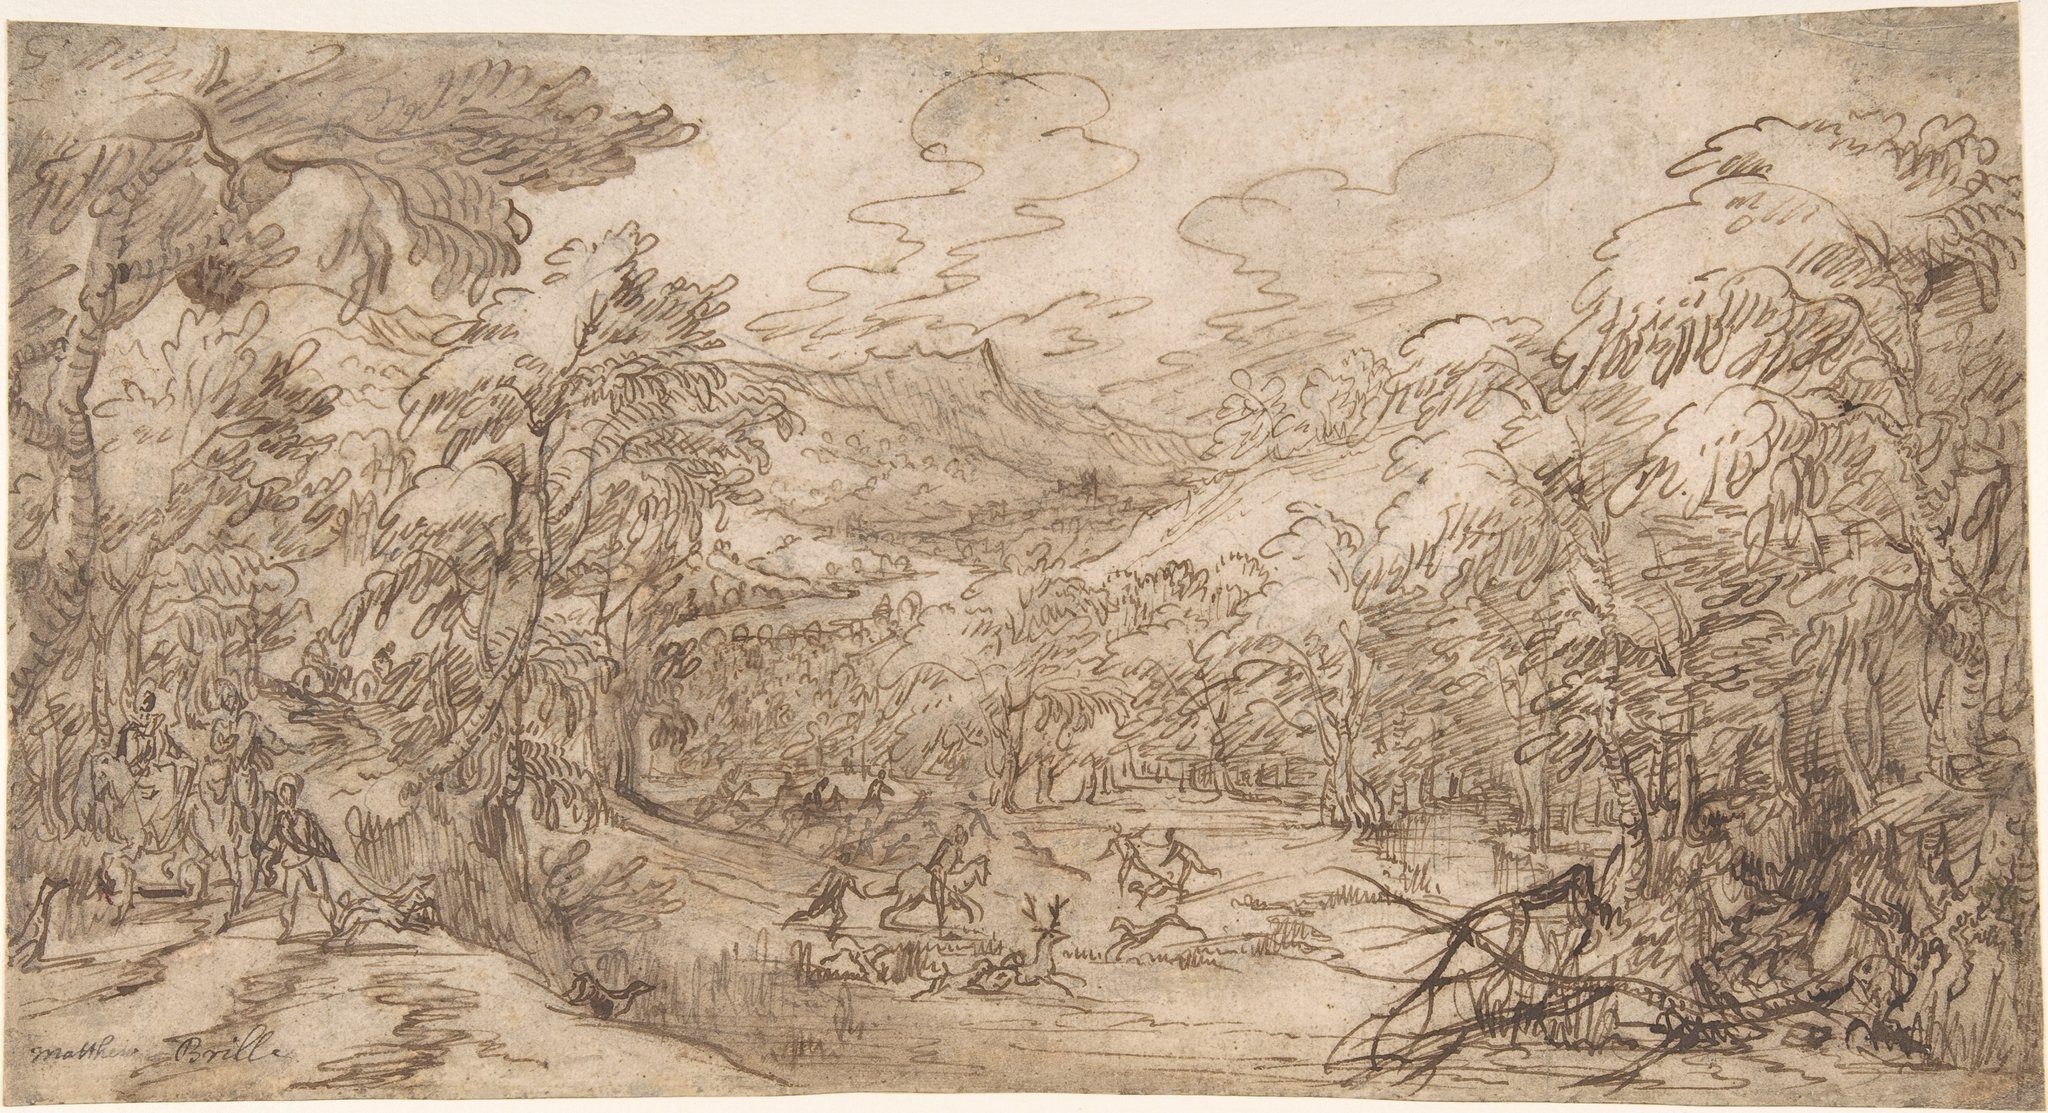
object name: drawing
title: Wooded Landscape with Stag Hunt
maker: tobias verhaecht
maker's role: artist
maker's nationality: netherlandish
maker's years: 1561-1631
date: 1567-1633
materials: chalk, ink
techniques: pen, wash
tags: human figures,hunting,deer,landscapes,trees